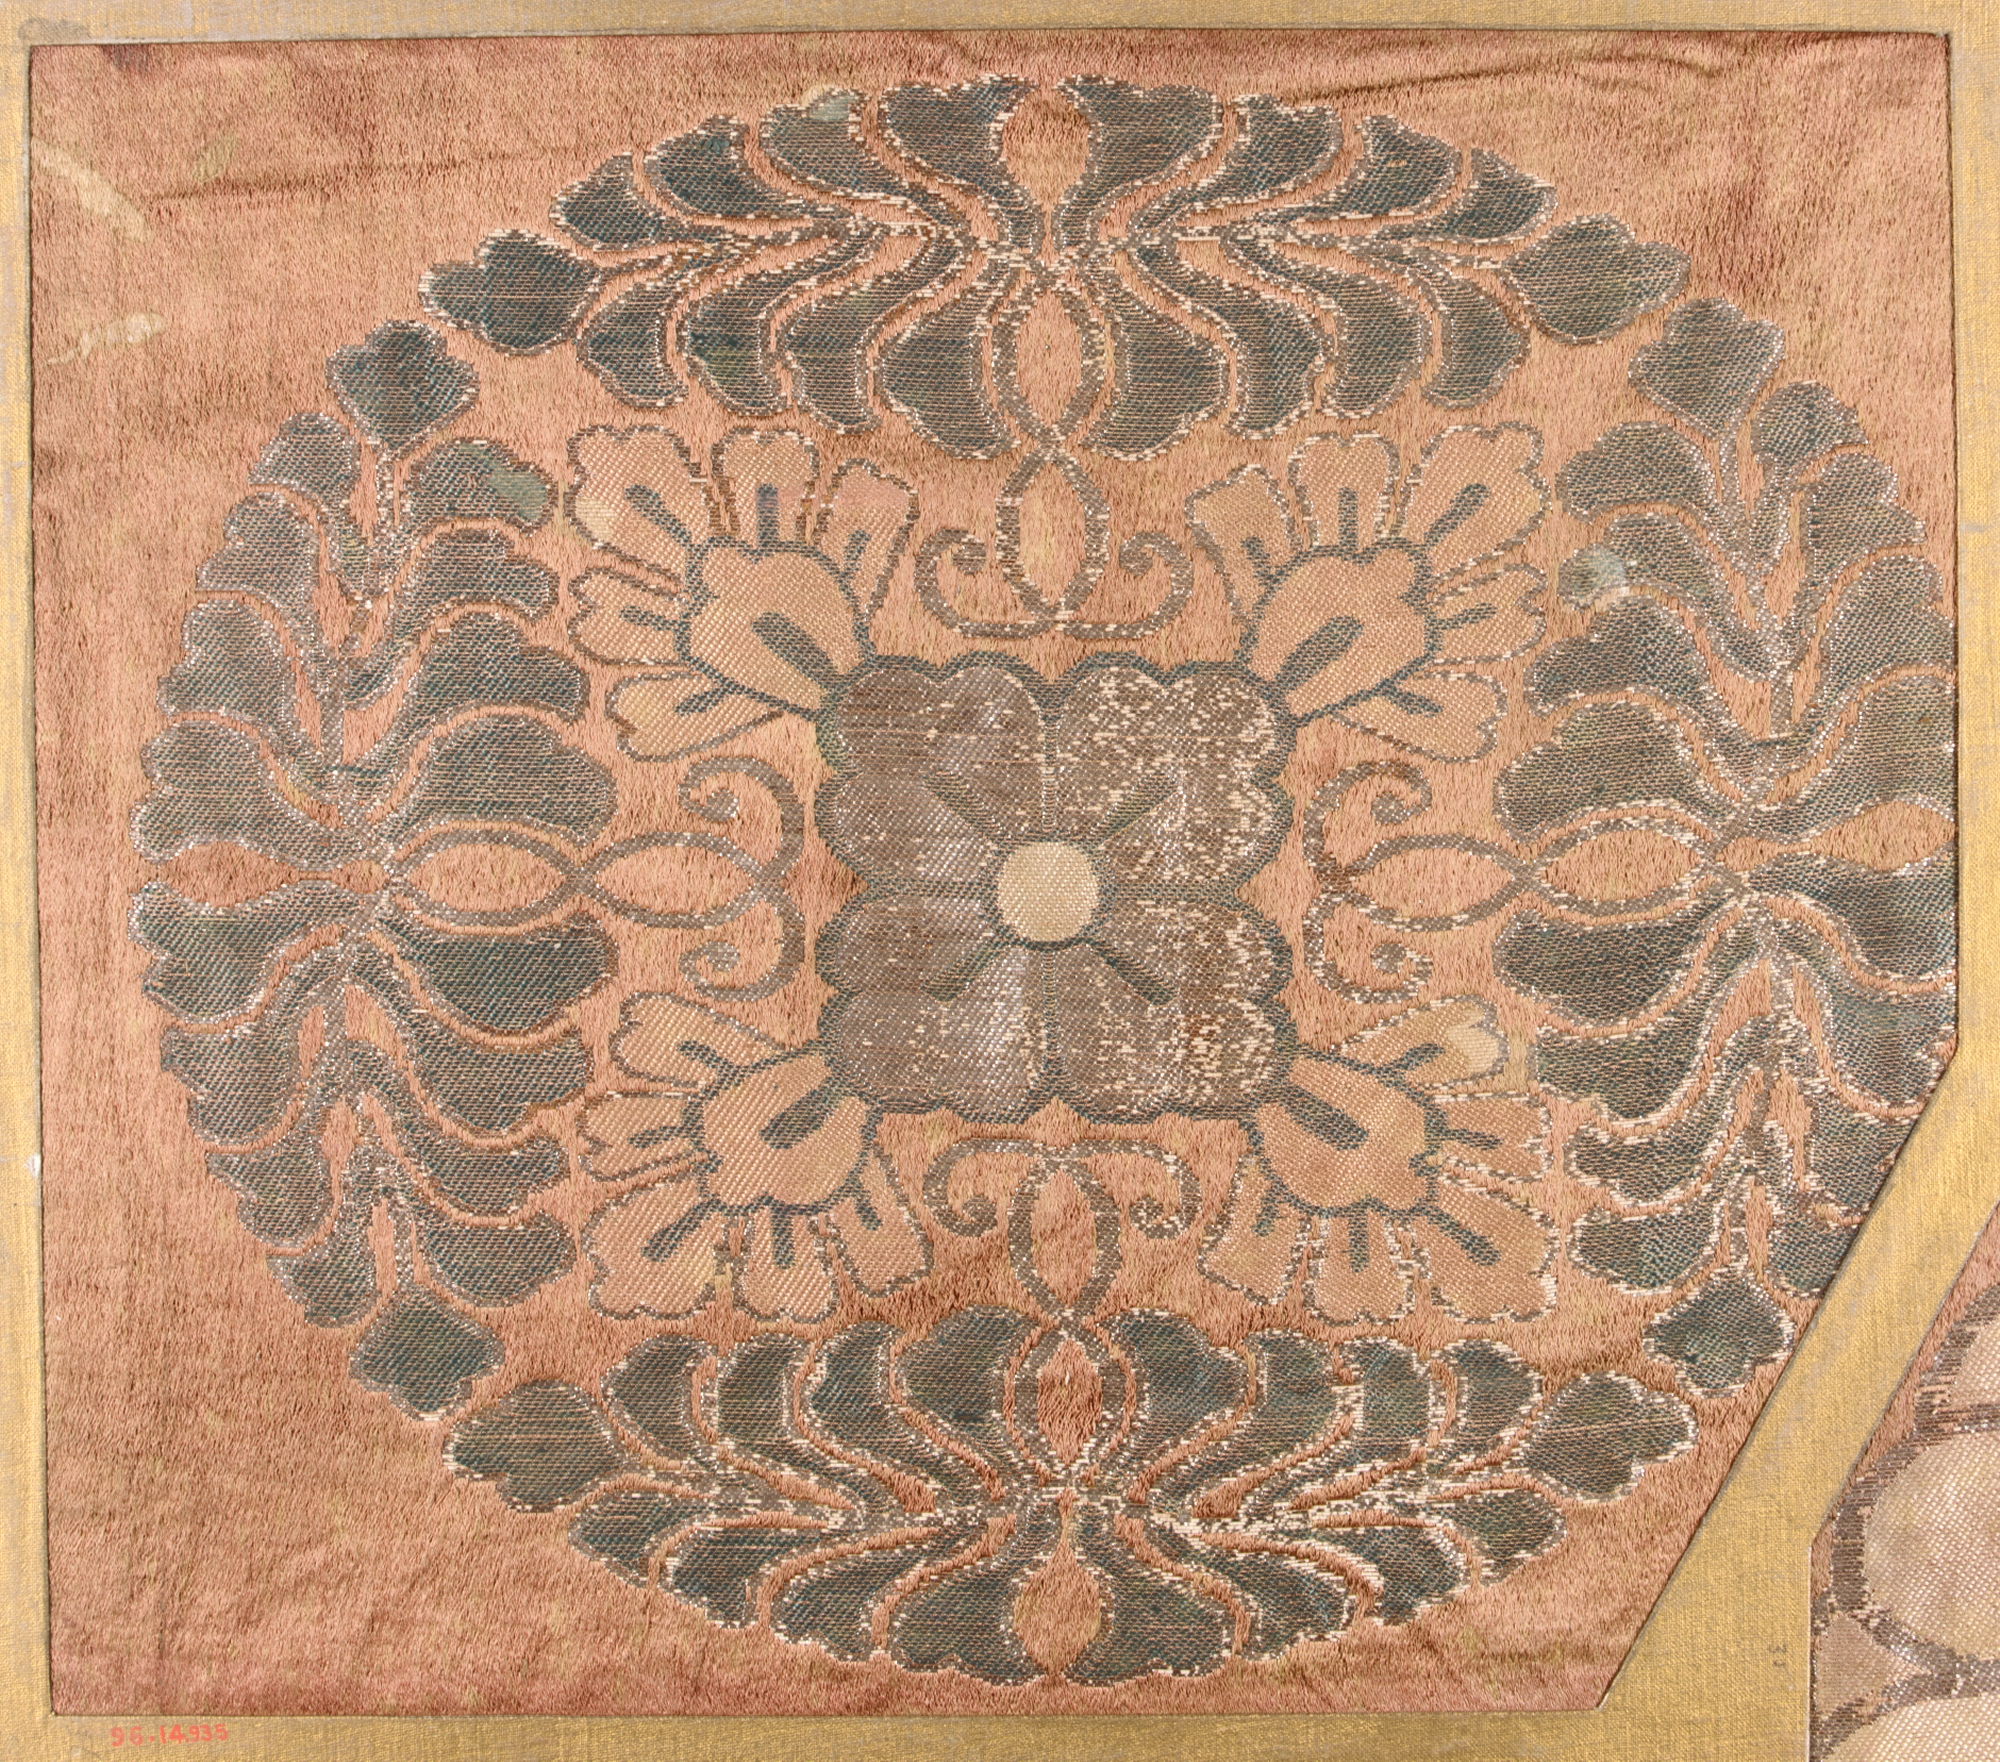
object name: piece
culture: japanese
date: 1701-1900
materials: silk